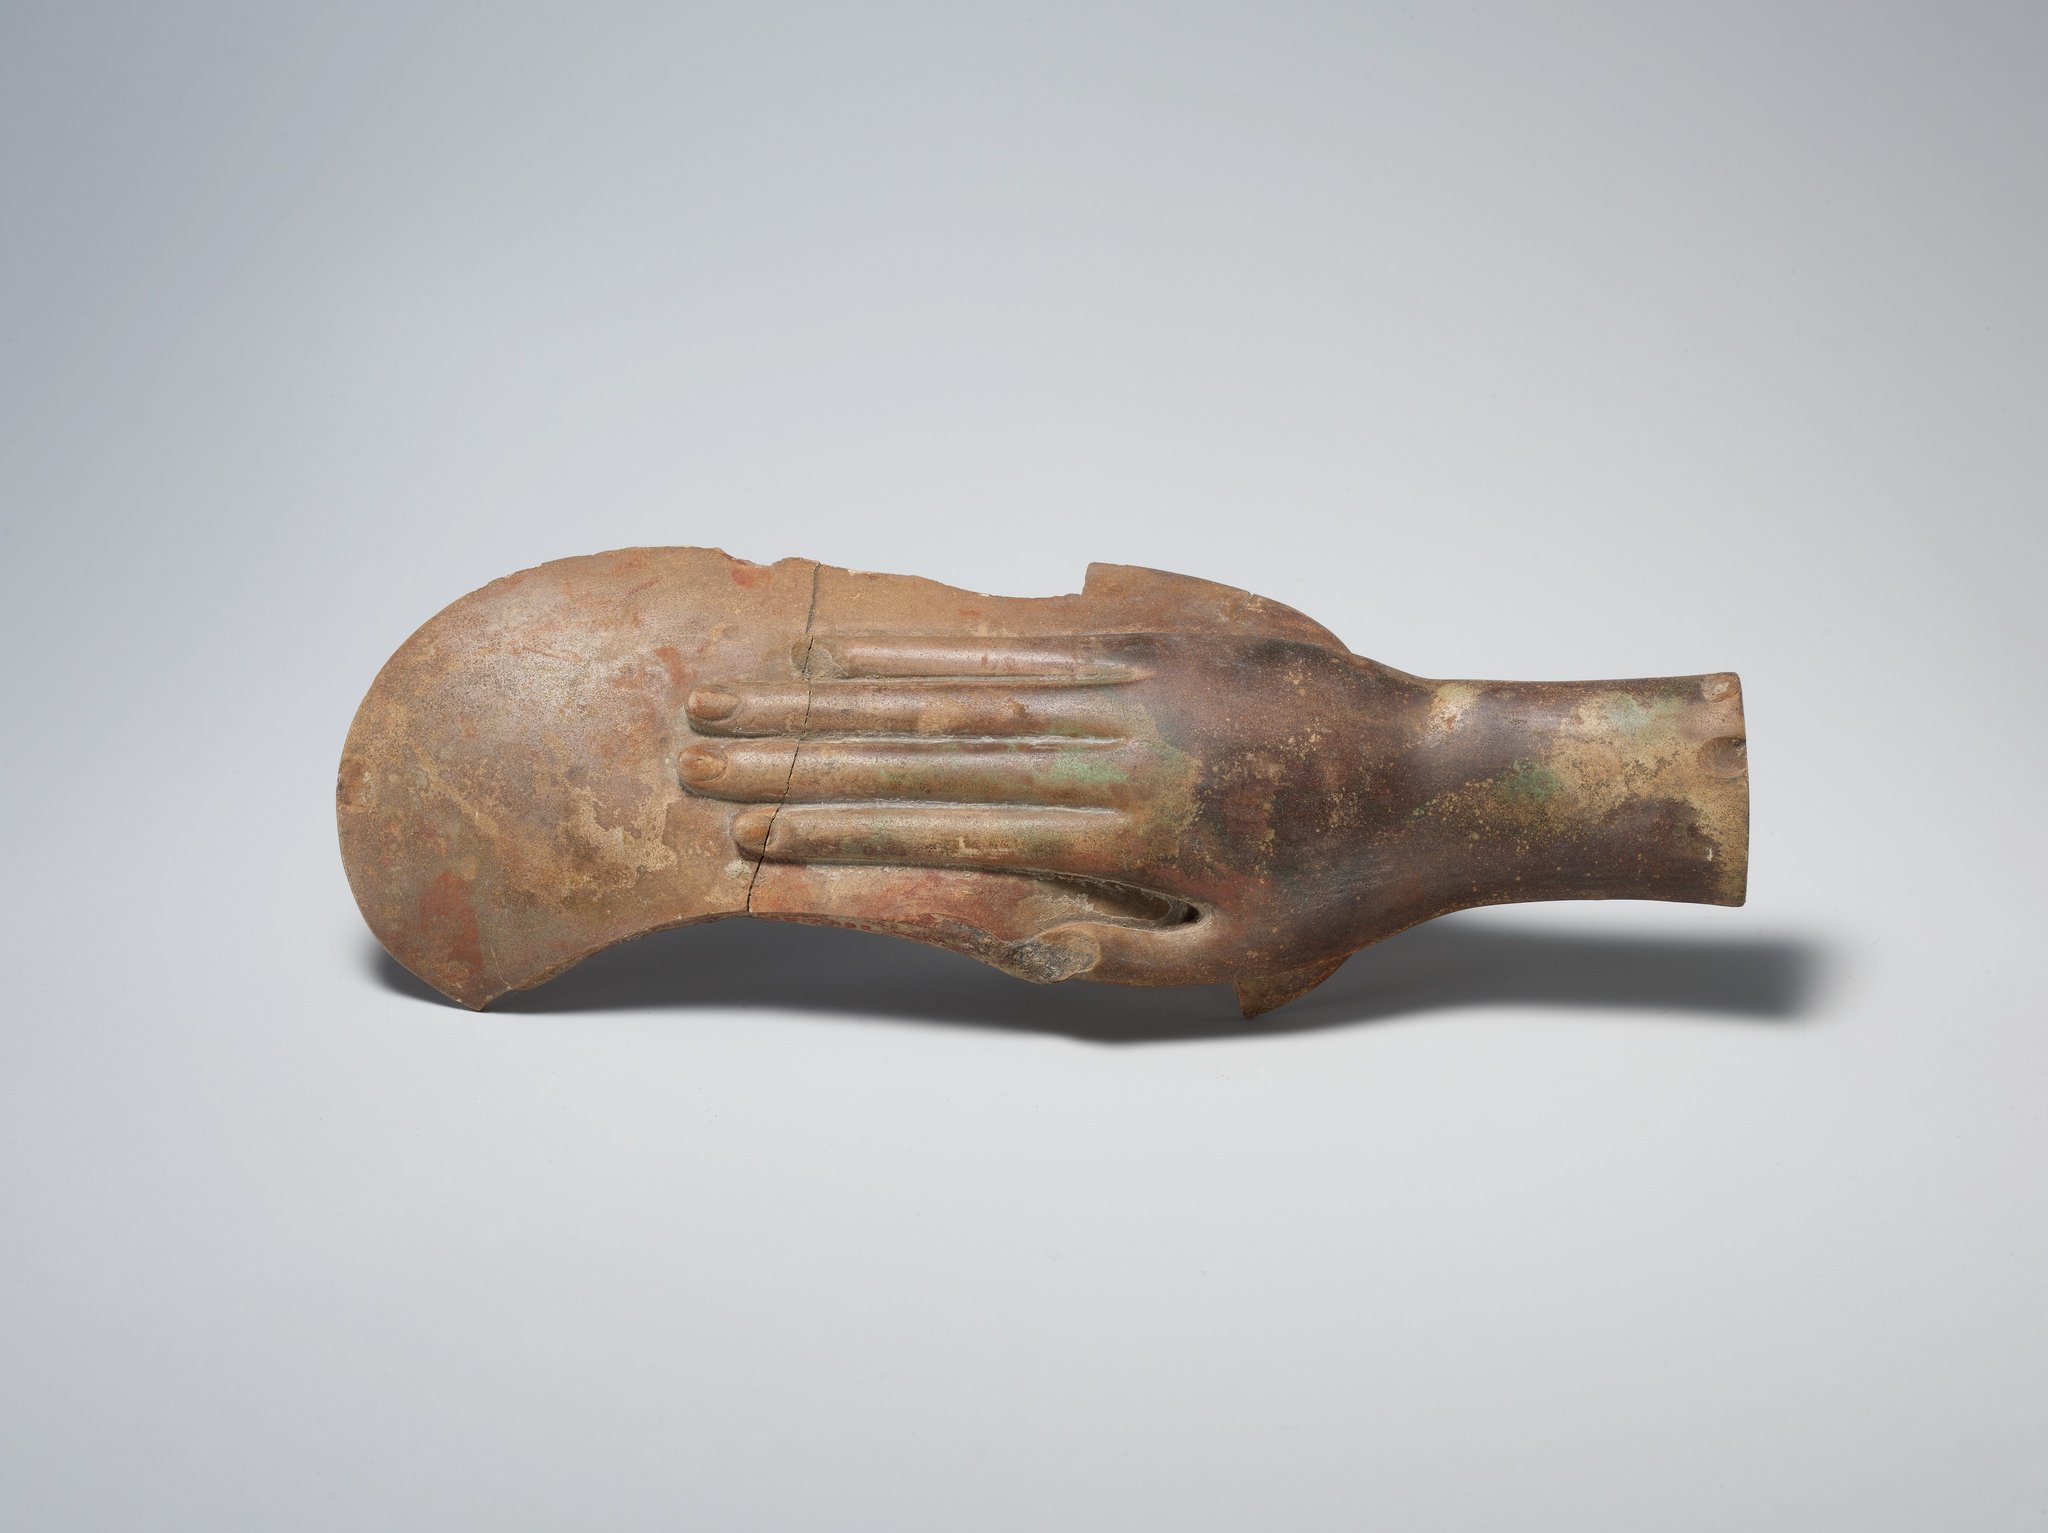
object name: decorated spoon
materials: faience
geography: egypt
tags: hands